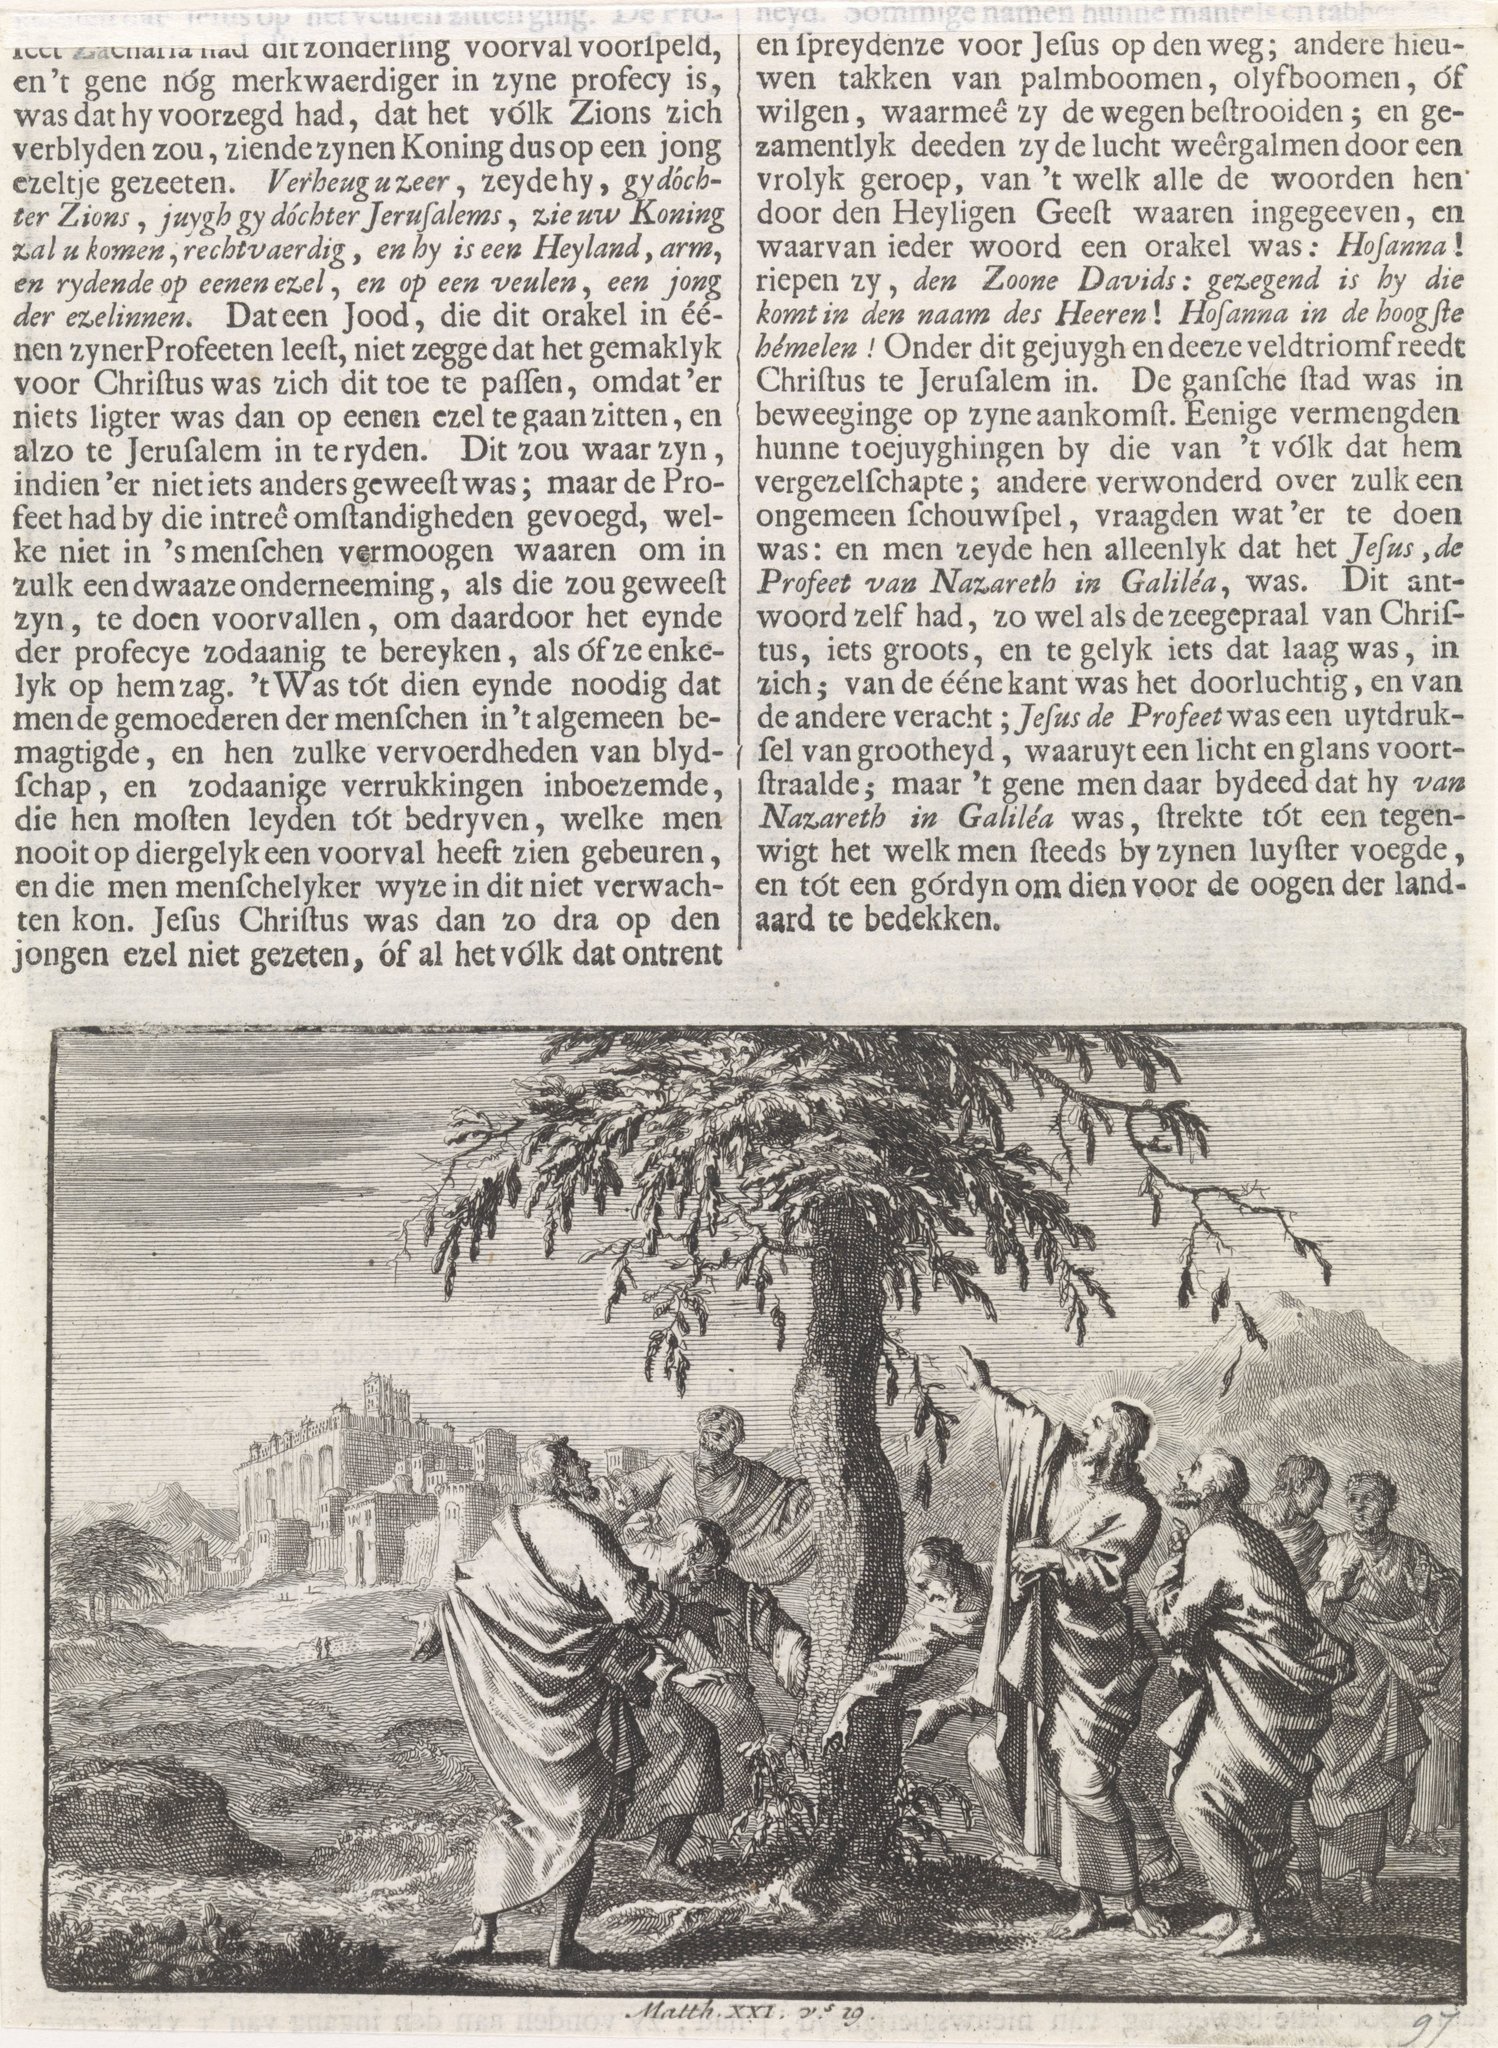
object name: print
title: Christus en het teken van de vijgenboom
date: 1703-1762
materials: paper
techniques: etching, letterpress printing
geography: haarlem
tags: the cursing of the fig-tree (matthew 21:18-22; mark 11:12-14, 11:20-21)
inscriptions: collector's mark: Lugt 2228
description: De prent komt een eerste keer voor als boekillustratie voor David Martin. Historie des Ouden en Nieuwen Testaments. Amsterdam, Pieter Mortier, 1703. Deel II. De boekillustraties voor de Mortierbijbel hebben verschillende staten en kopieën, waarbij de chronologische volgorde moeilijk te achterhalen valt. Als boekillustraties werden ze bovendien herhaaldelijk opnieuw gebruikt voor andere boekwerken.